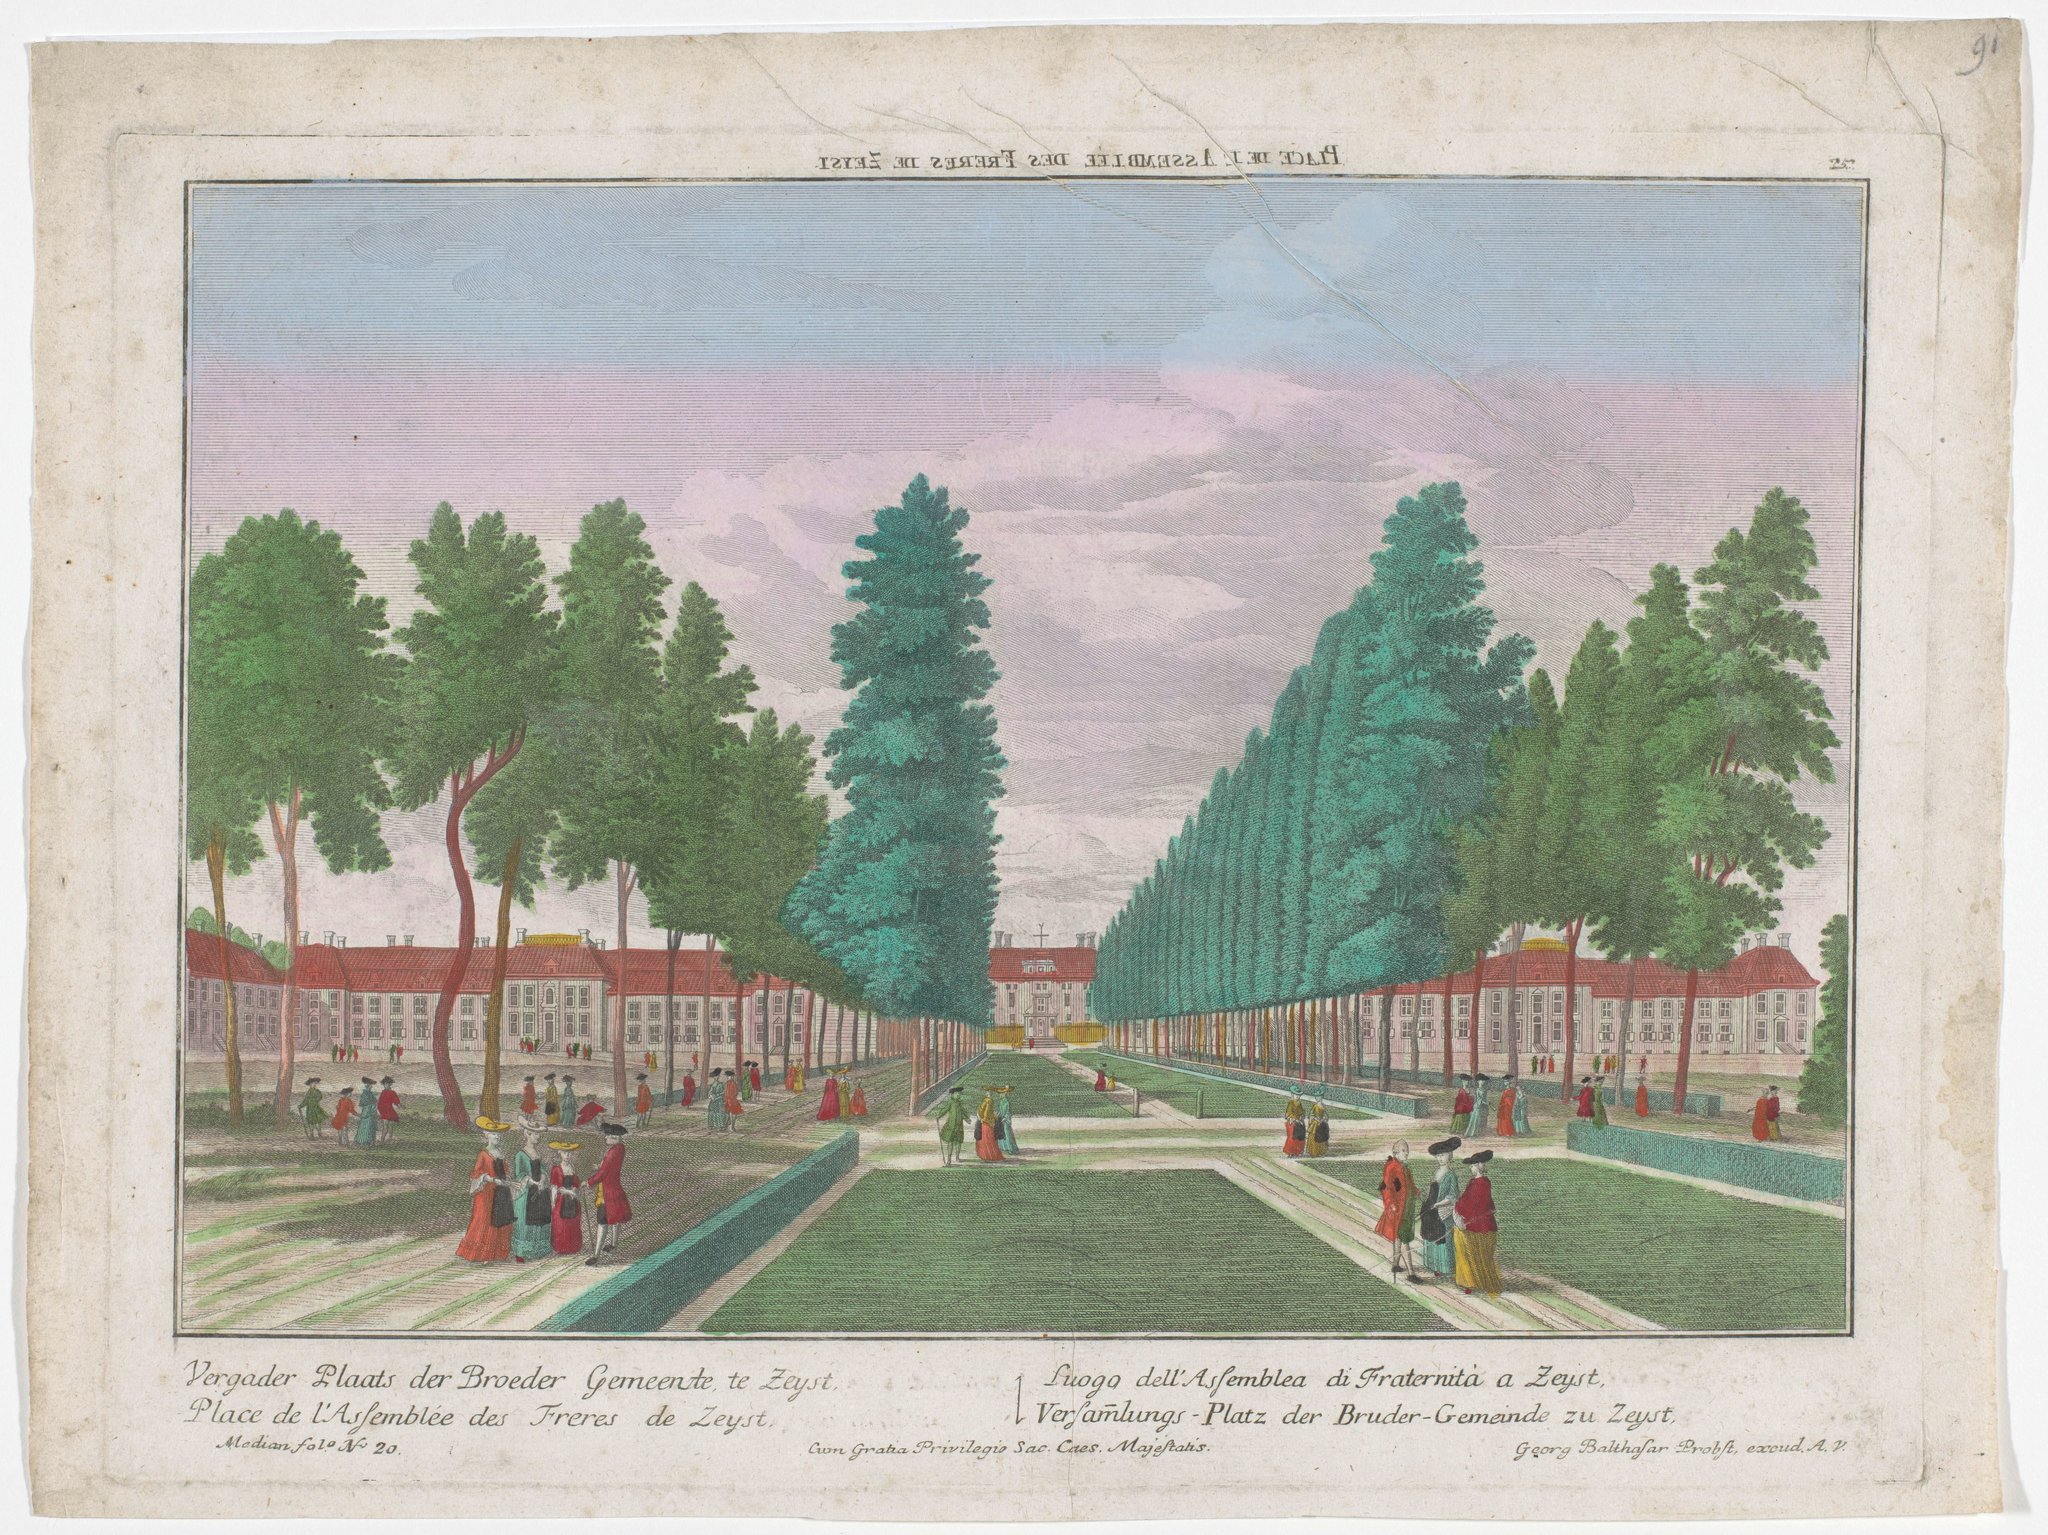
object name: opticaprent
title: Zeist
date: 1742-1801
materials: paper, watercolor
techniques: brush, etching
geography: augsburg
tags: castle, church (exterior), zeist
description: De serie “Zeist”, met het nummer 20, bevat vier prenten met de nummers 25-28, waarvan dit nummer 25 is.